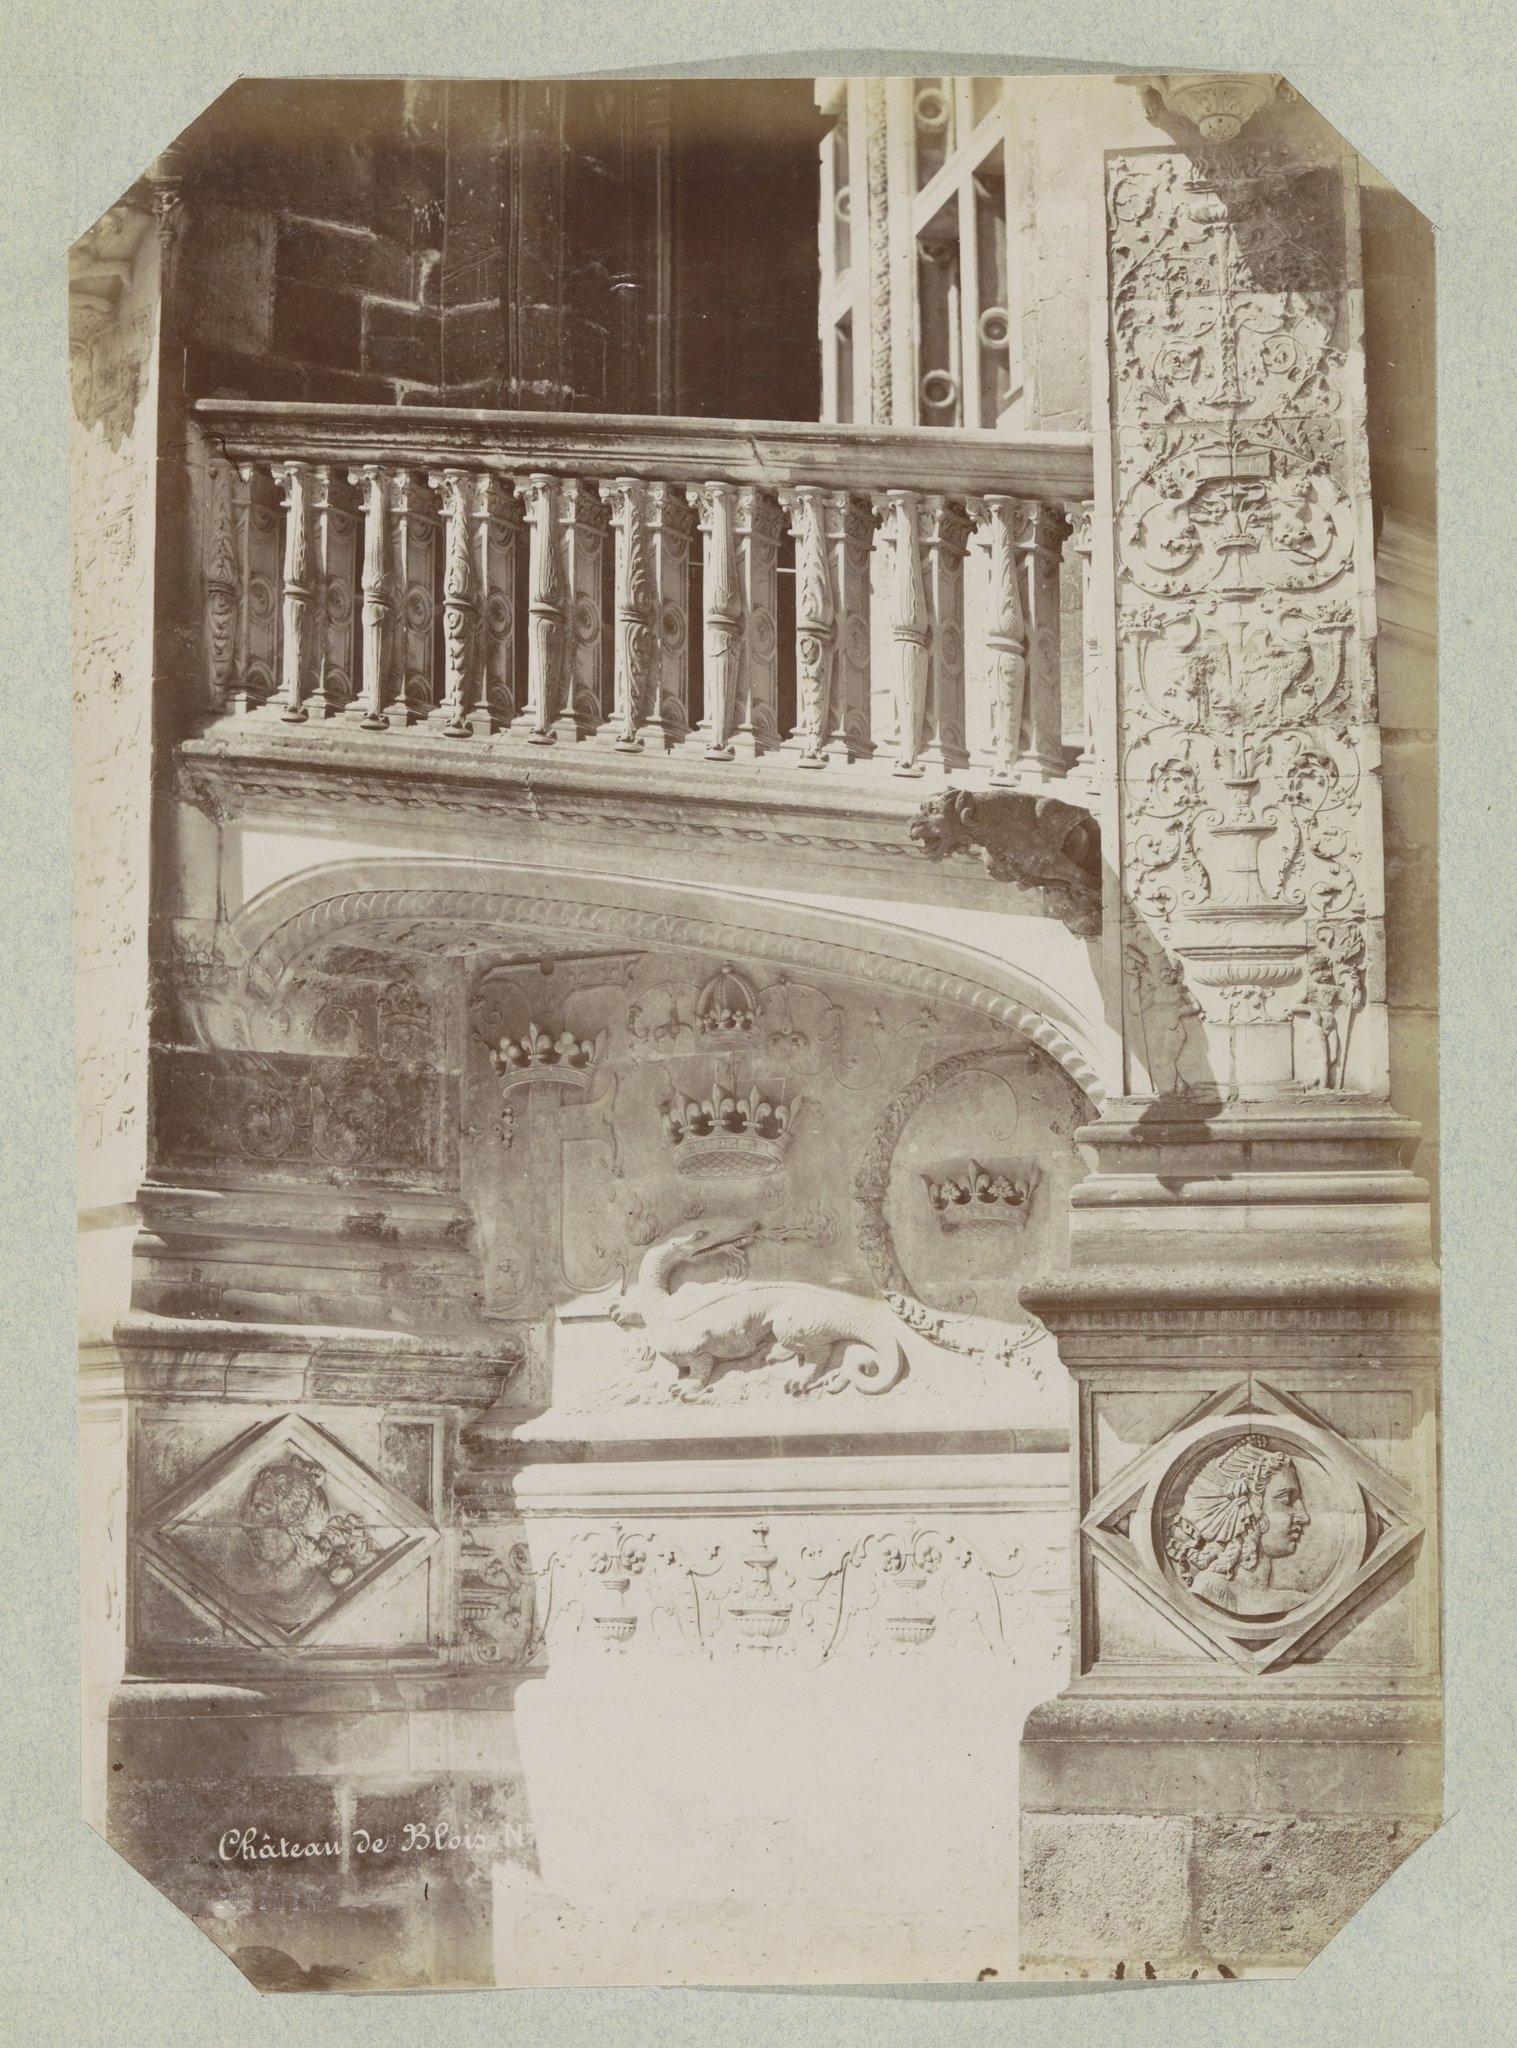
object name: photograph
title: Château de Blois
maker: séraphin-médéric mieusement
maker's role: fotograaf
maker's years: 1840-1905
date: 1880-1900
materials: photographic support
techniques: albumen print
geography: blois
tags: salamander (fabulous animal); salamander as spirit of fire, staircase, sculpture (+ relief ~ sculpture)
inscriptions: name: ‘Mieusement photographe’, number: ‘[...]’, inscription: ‘Monuments Historiques’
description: Onderdeel van Fotoalbum met opnames van monumenten in Frankrijk.